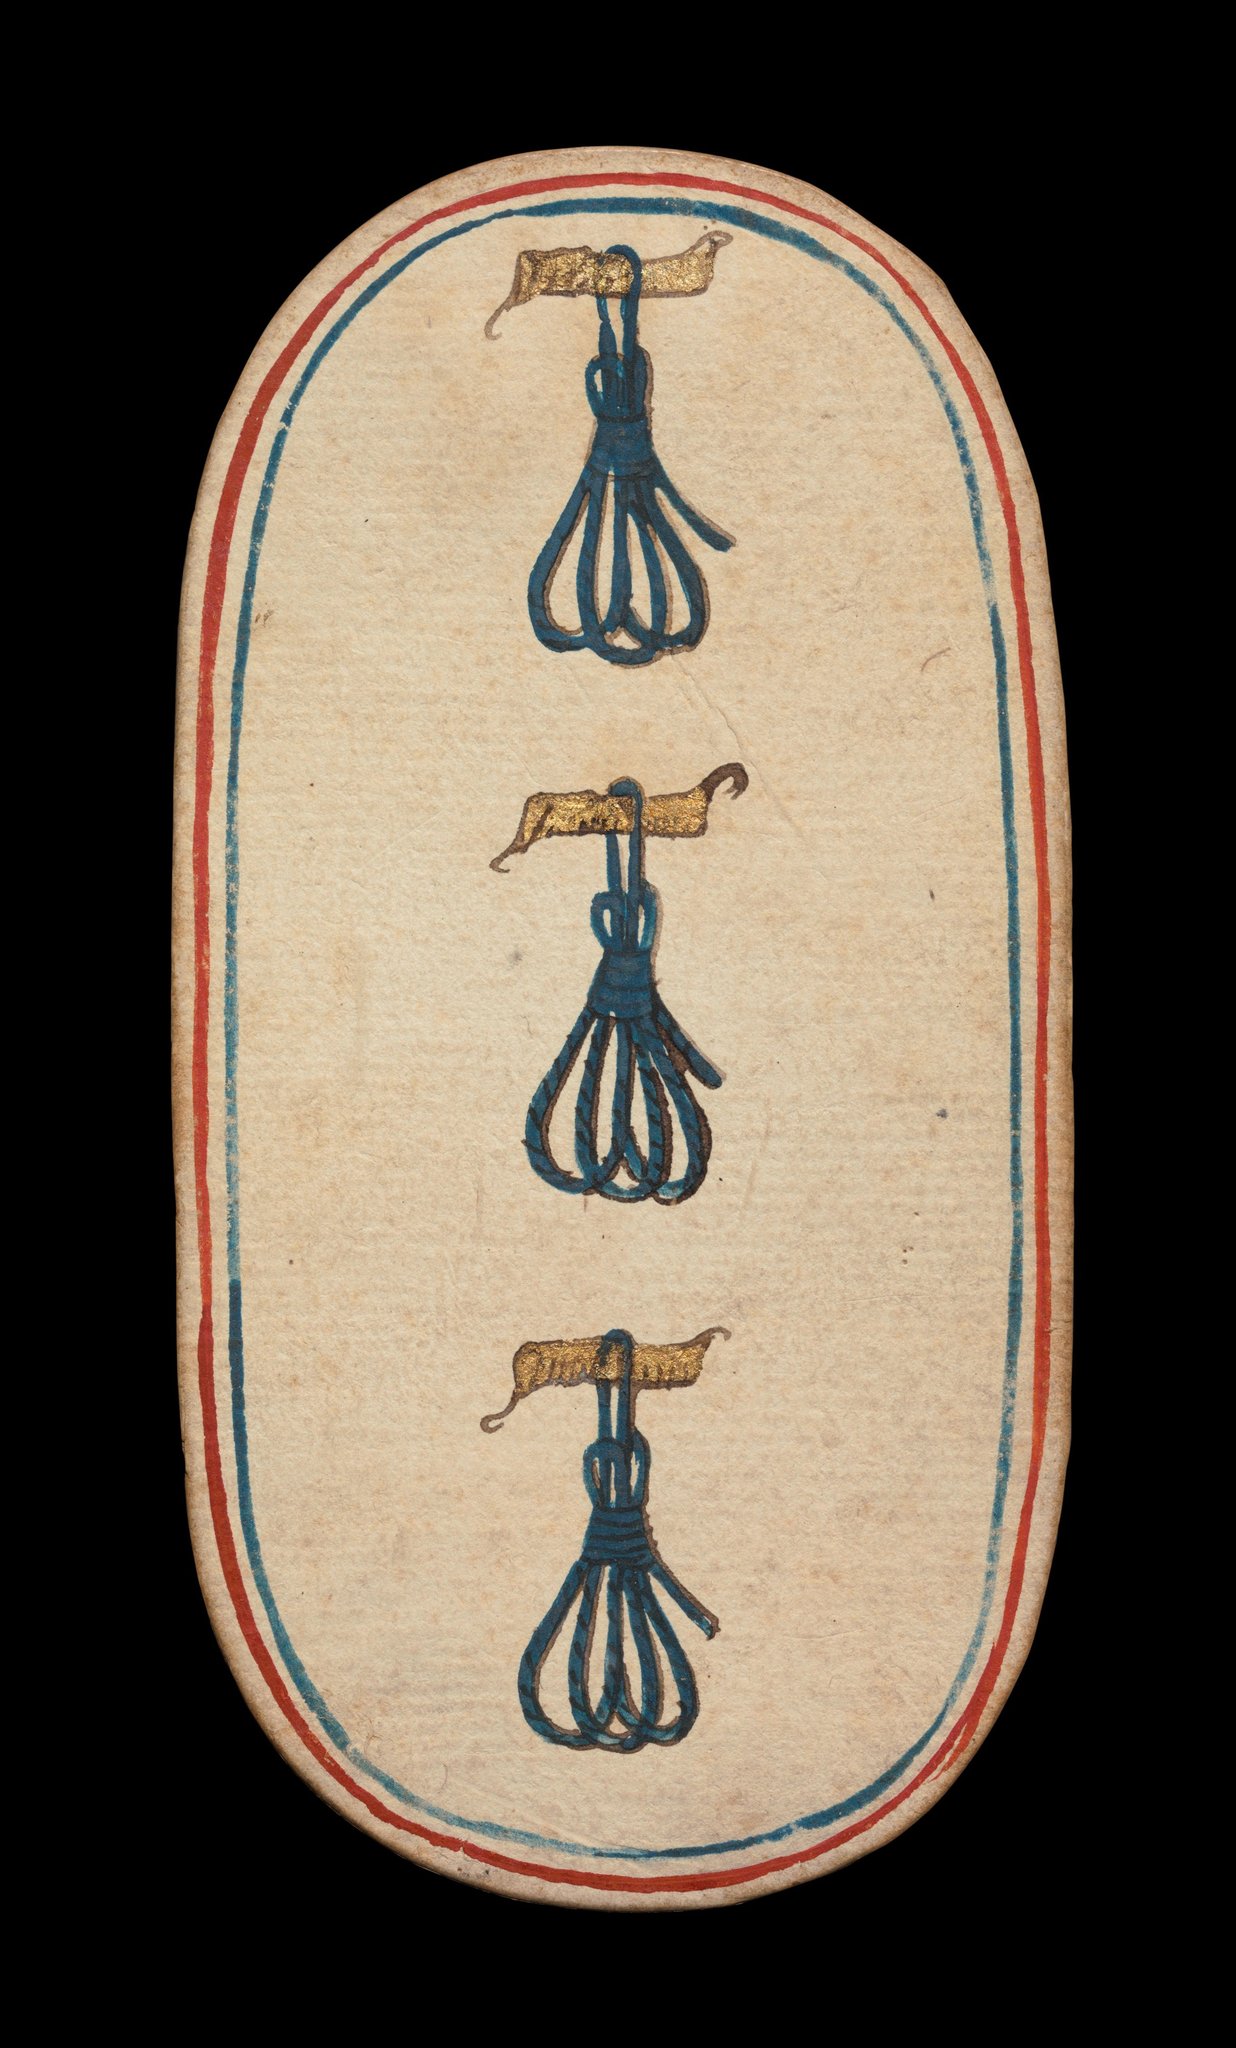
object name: playing card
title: 3 of Tethers, from The Cloisters Playing Cards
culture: south netherlandish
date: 1475-1480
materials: glaze, gold, ink, paint, paper, silver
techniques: pen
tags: playing cards,games